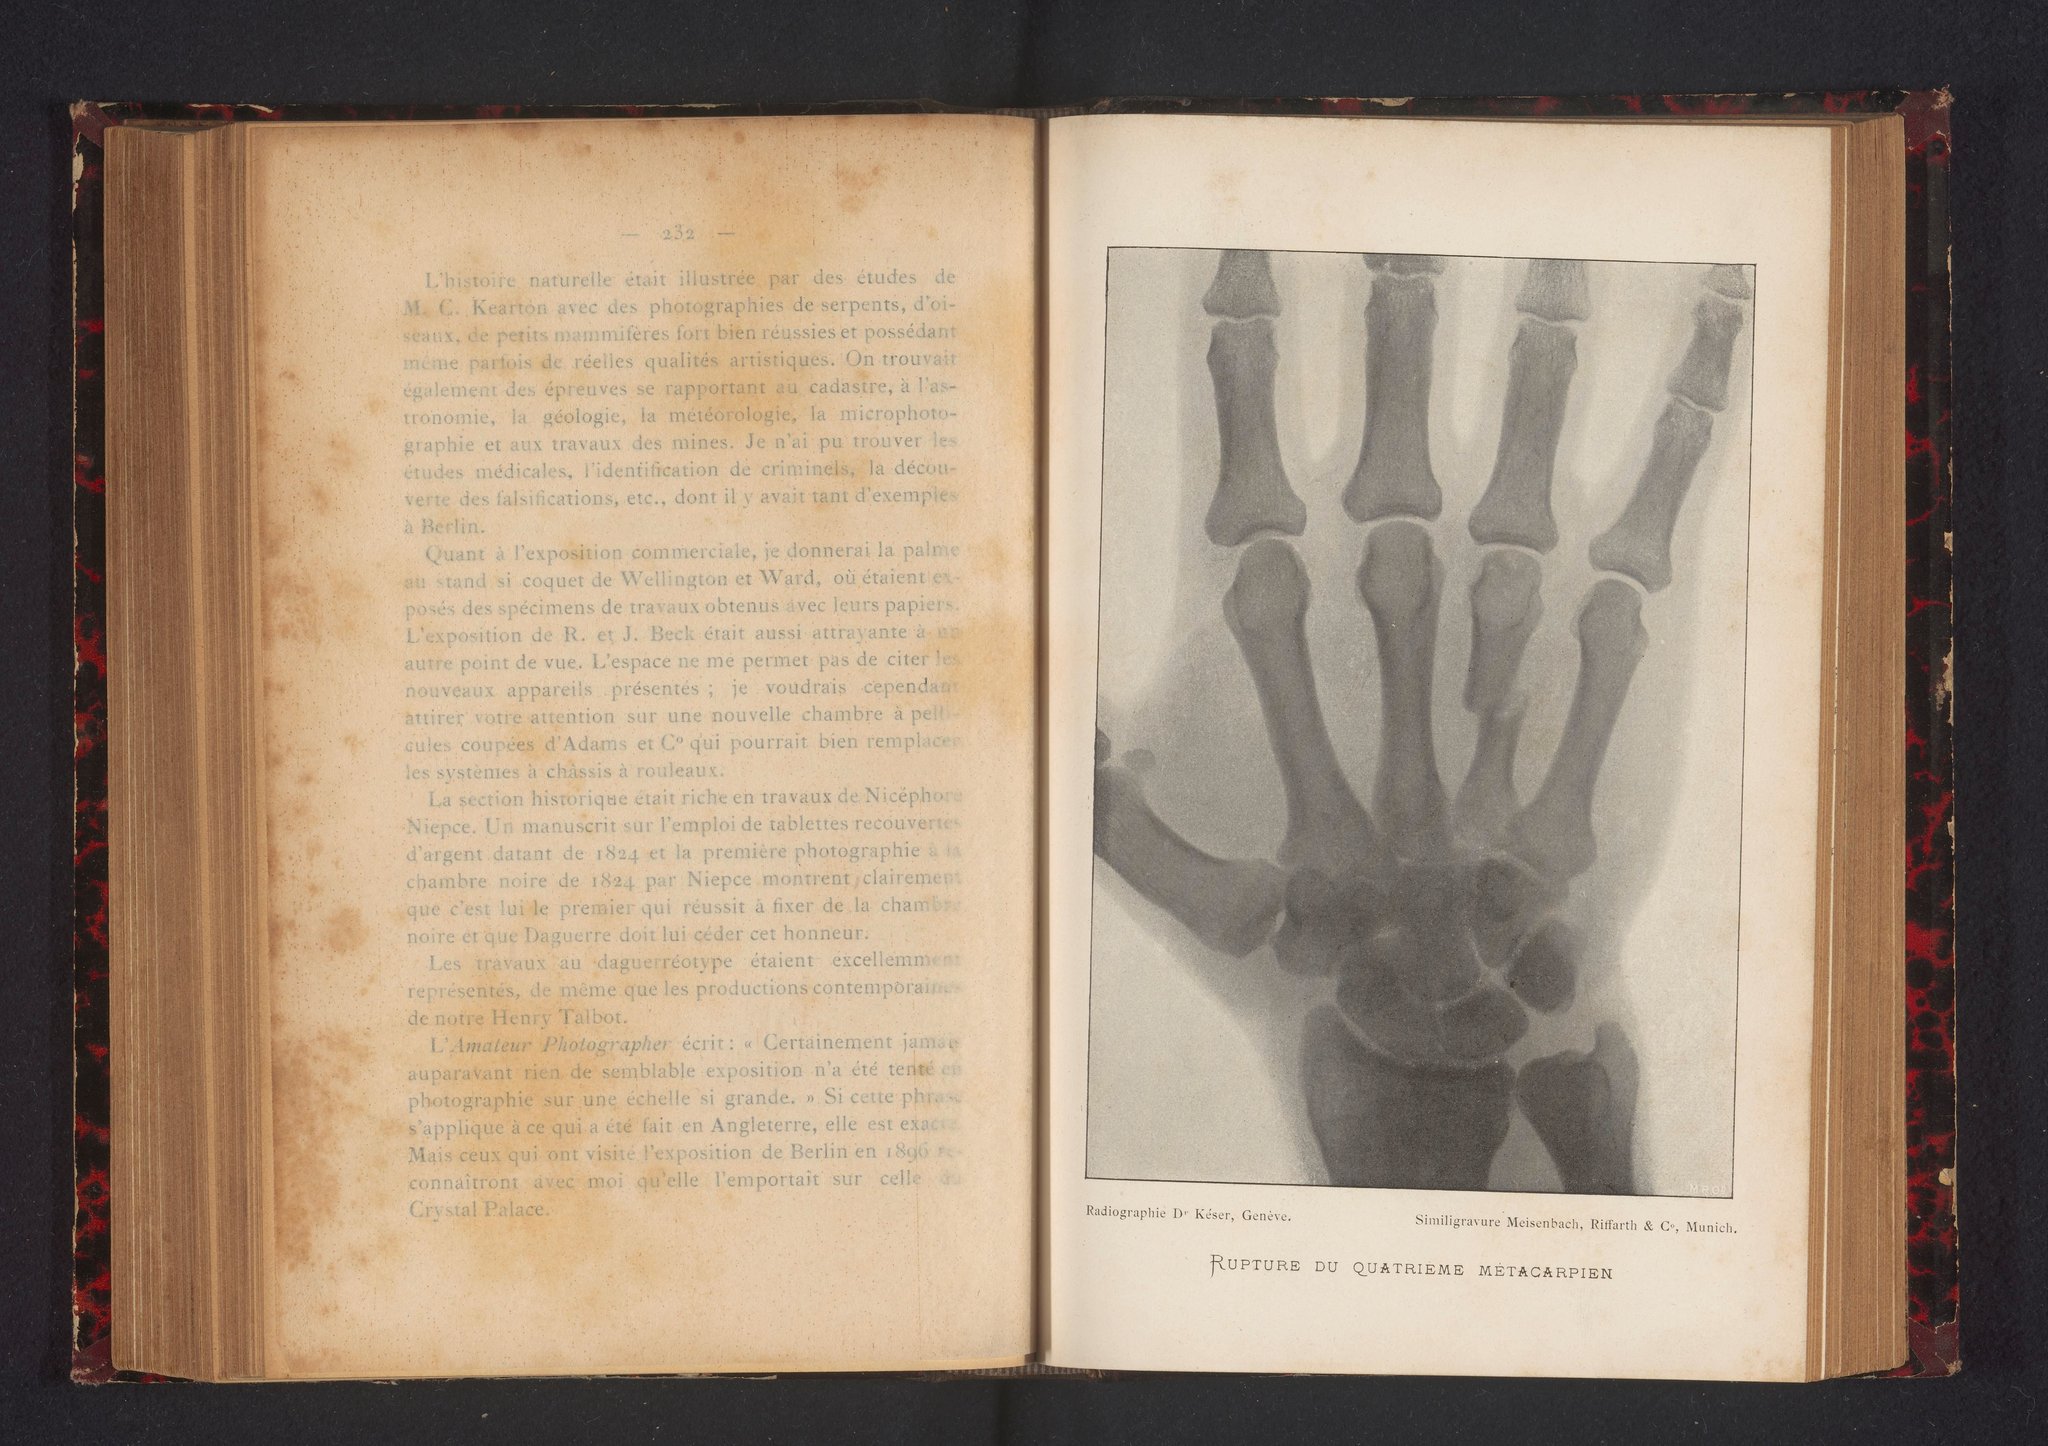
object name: page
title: Röntgenfoto van een hand met gebroken middenhandsbeentje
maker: dr. késer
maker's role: fotograaf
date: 1893-1898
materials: paper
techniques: autotype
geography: munich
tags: carpus and metacarpus, parts of the hand, x-ray examination